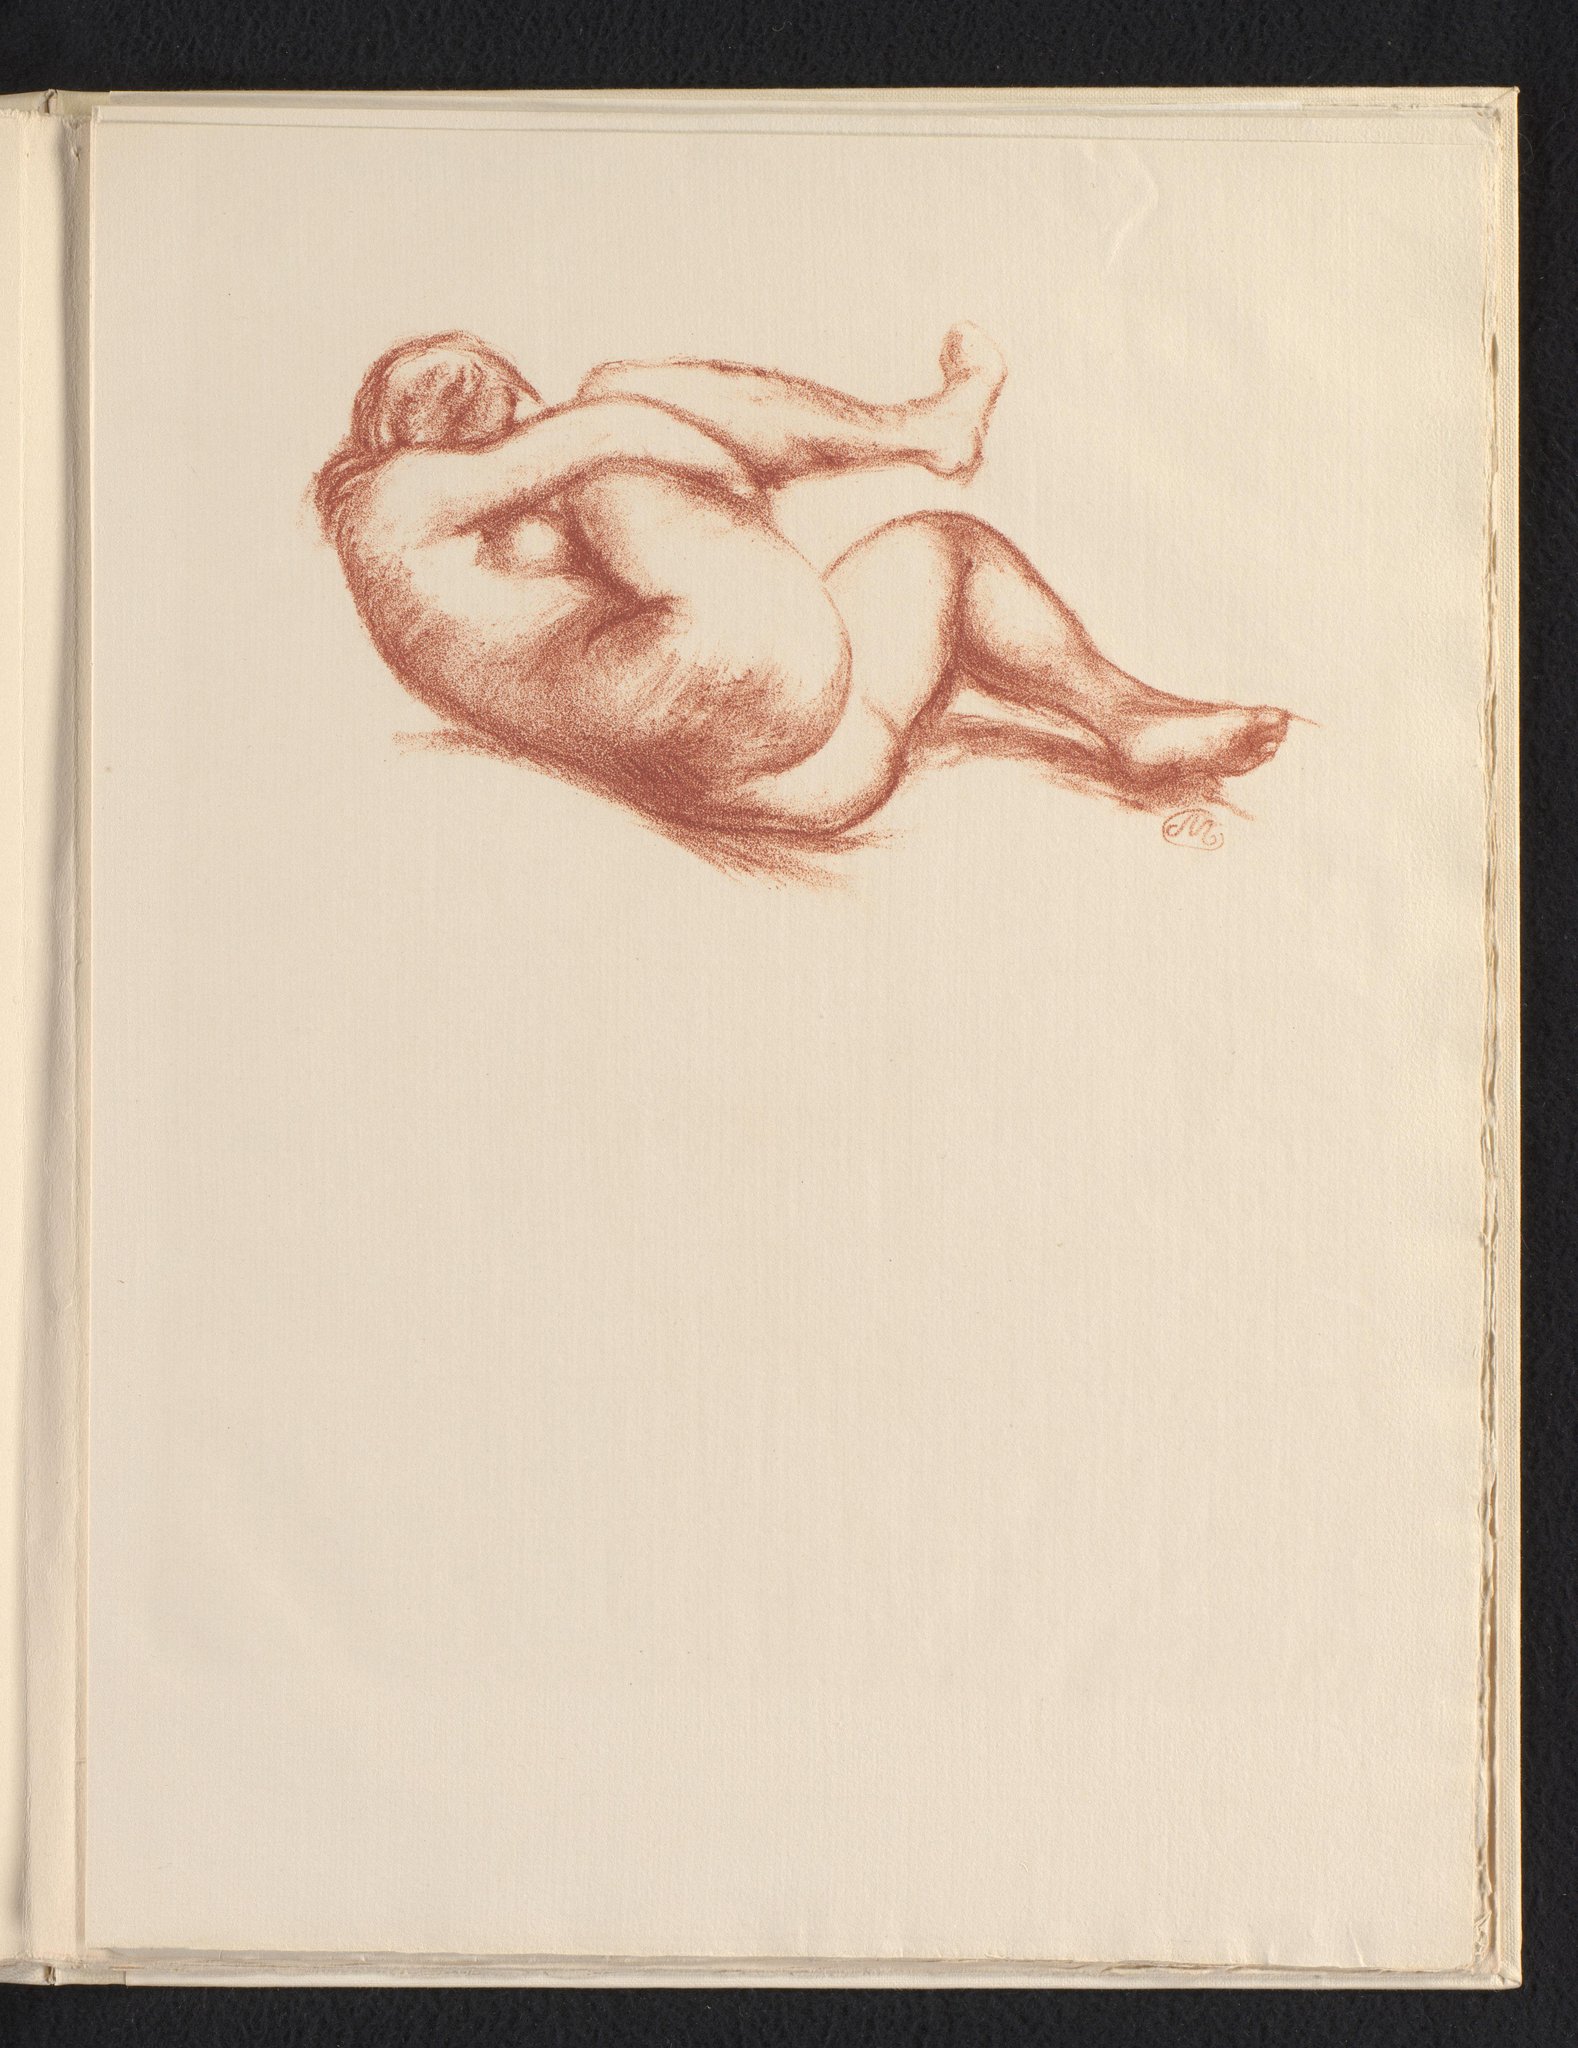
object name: book illustration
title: Op haar rug liggende naakte vrouw, een arm om haar rechter knieholte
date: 1948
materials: paper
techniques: lithograph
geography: paris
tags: woman (showing herself) undressed, quasi-nude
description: Prent uit: Lucianus van Samosata. Dialogues des Courtisanes. [Vertaald uit het Grieks door] Charles Astruc. Parijs: s.n., 1948, deel van de suite met een extra afdruk van de prenten in sanguine.